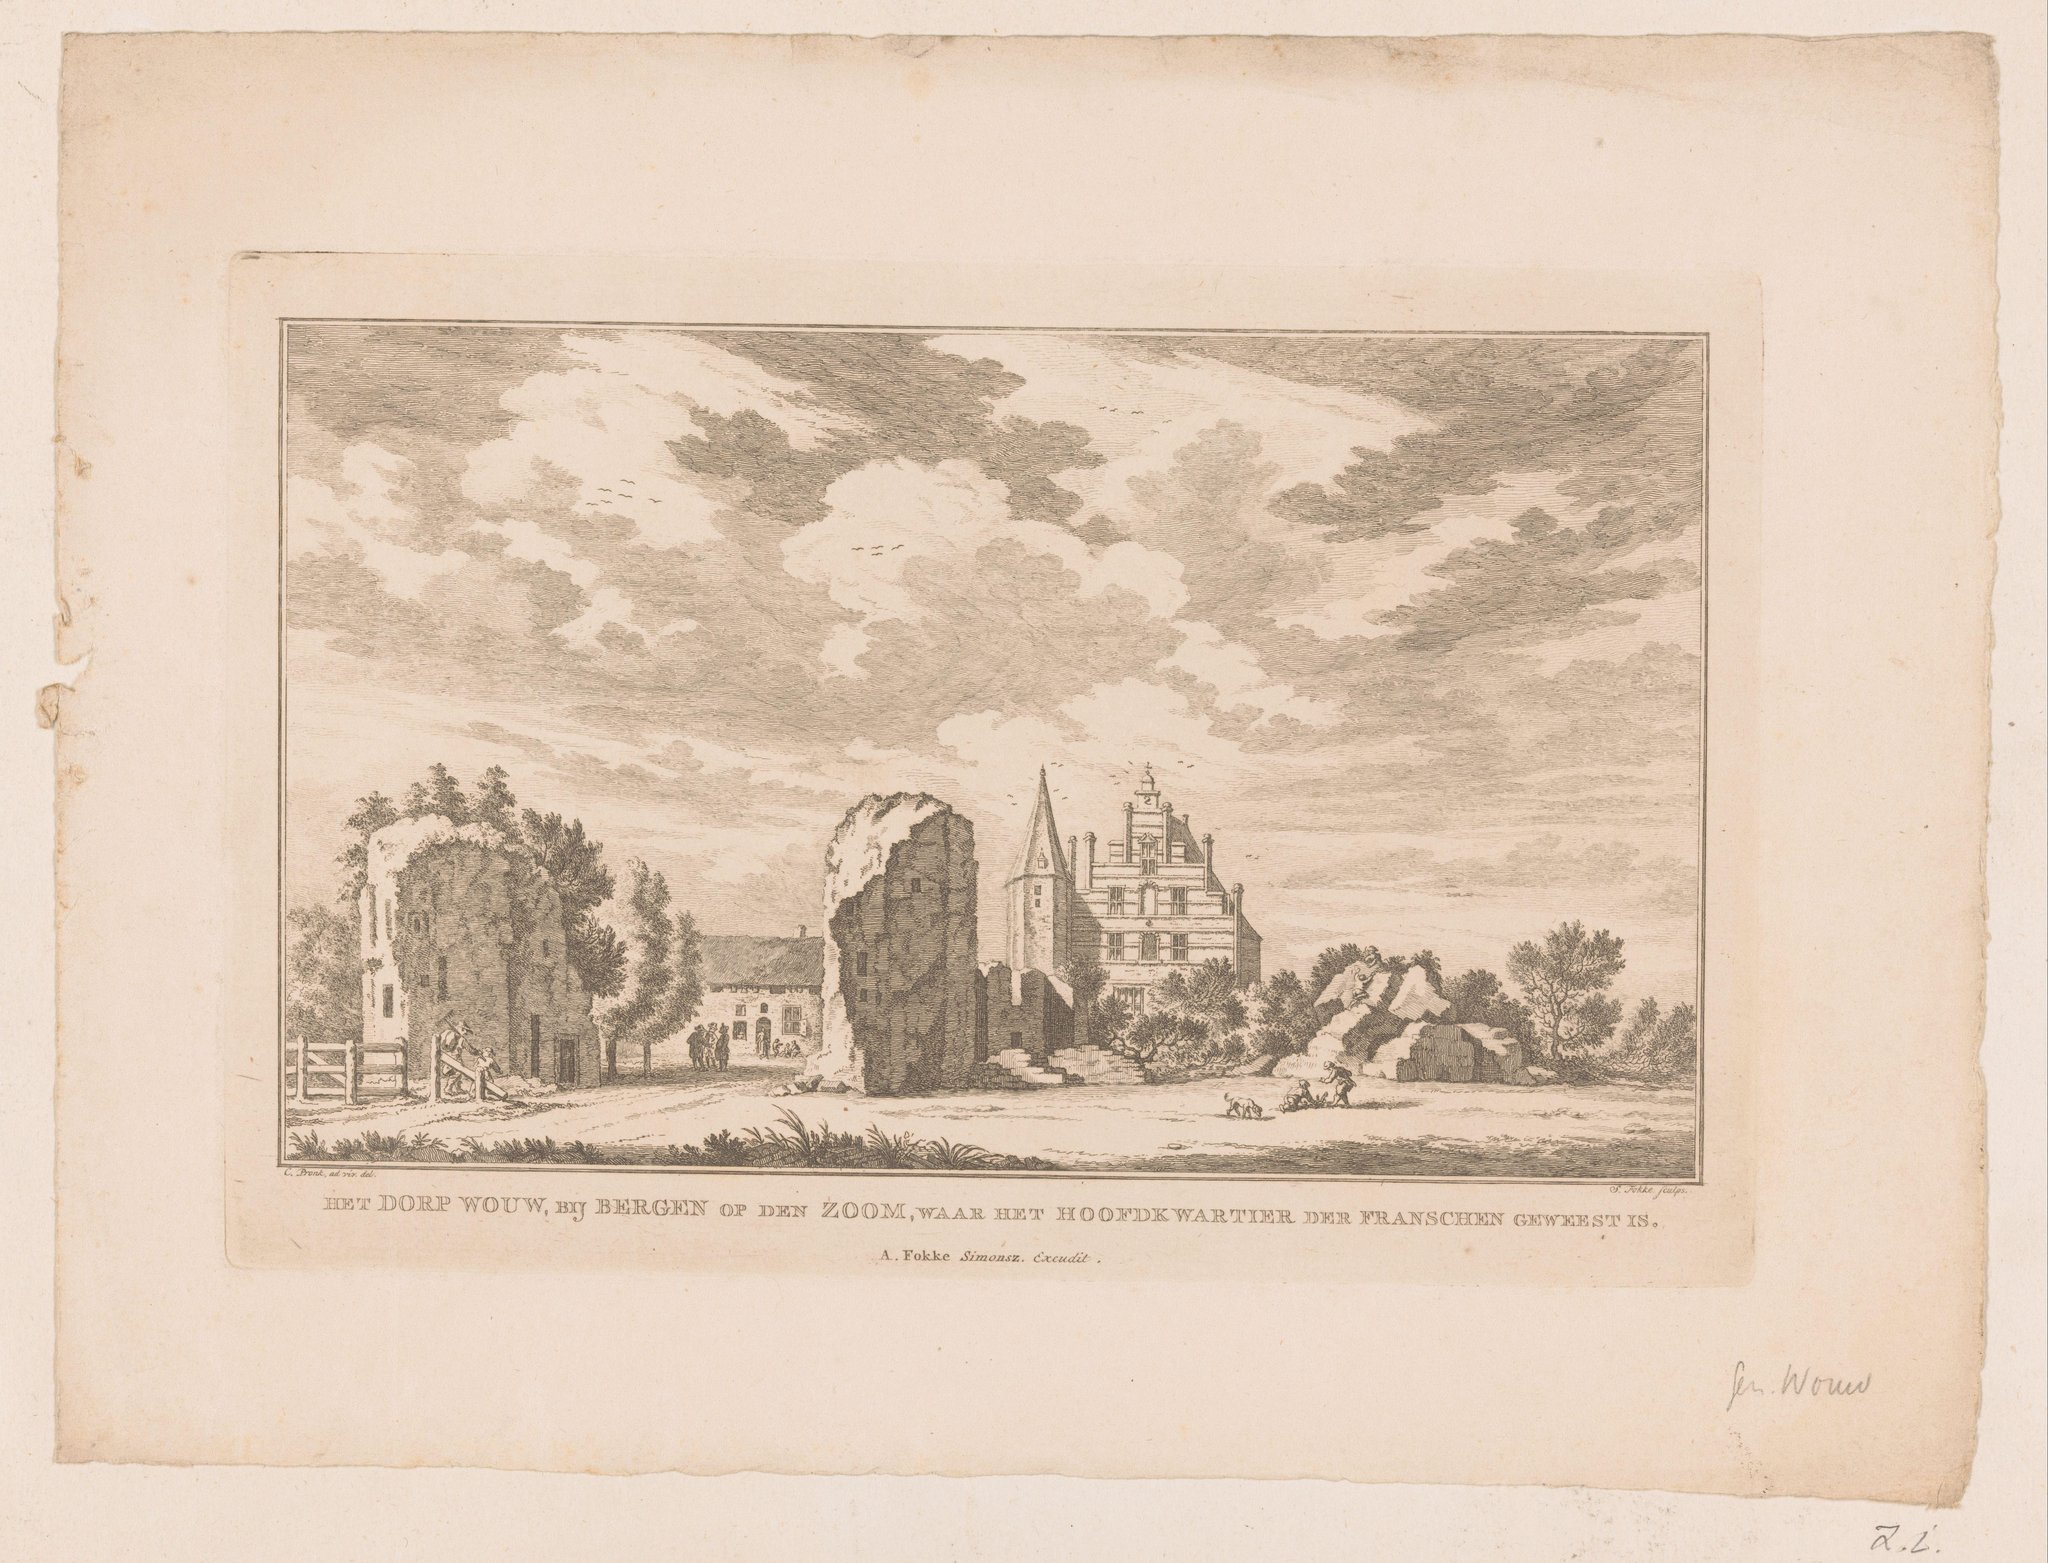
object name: print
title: 10 Gezichten van het beleg en de verwoesting van Bergen op Zoom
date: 1772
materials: paper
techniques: etching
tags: siege, bergen op zoom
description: Muller geeft aan dat de prenten door Simon Fokke in 1772 naar de tekeningen van Pronk uit 1748 zijn vervaardigd.